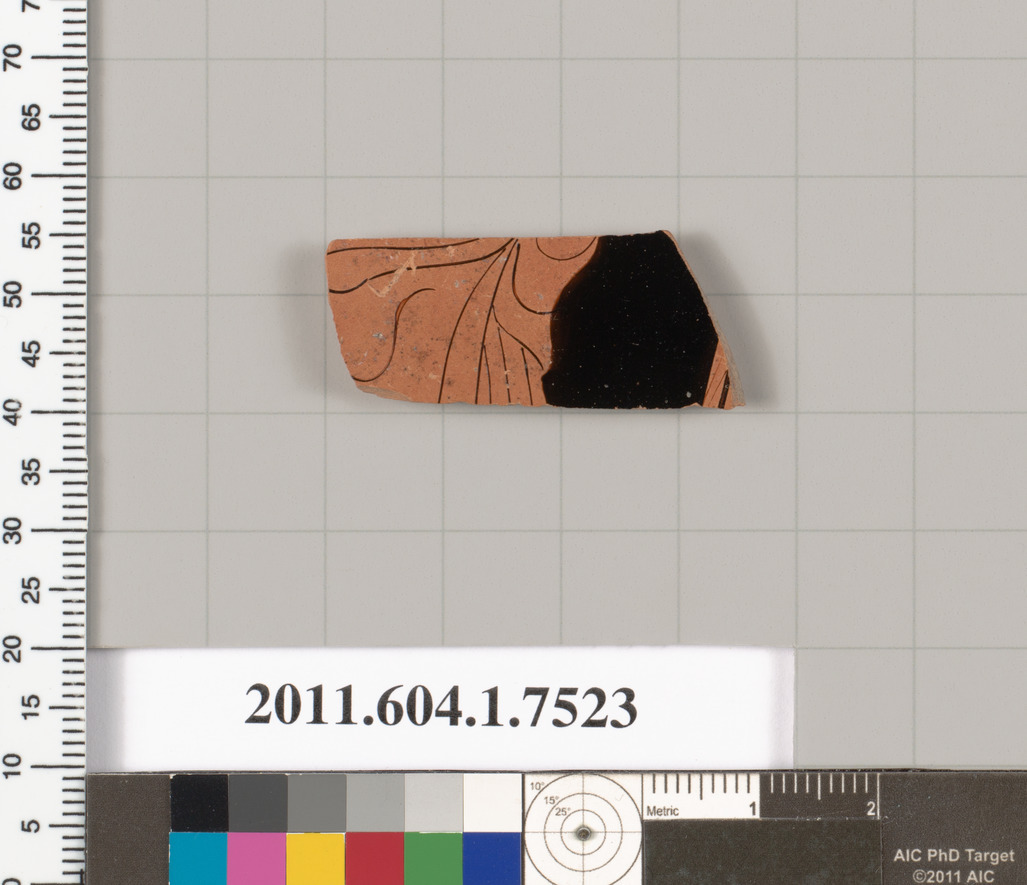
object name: kylix fragment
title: Terracotta fragment of a kylix (drinking cup)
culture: greek, attic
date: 460-450 BCE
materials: terracotta